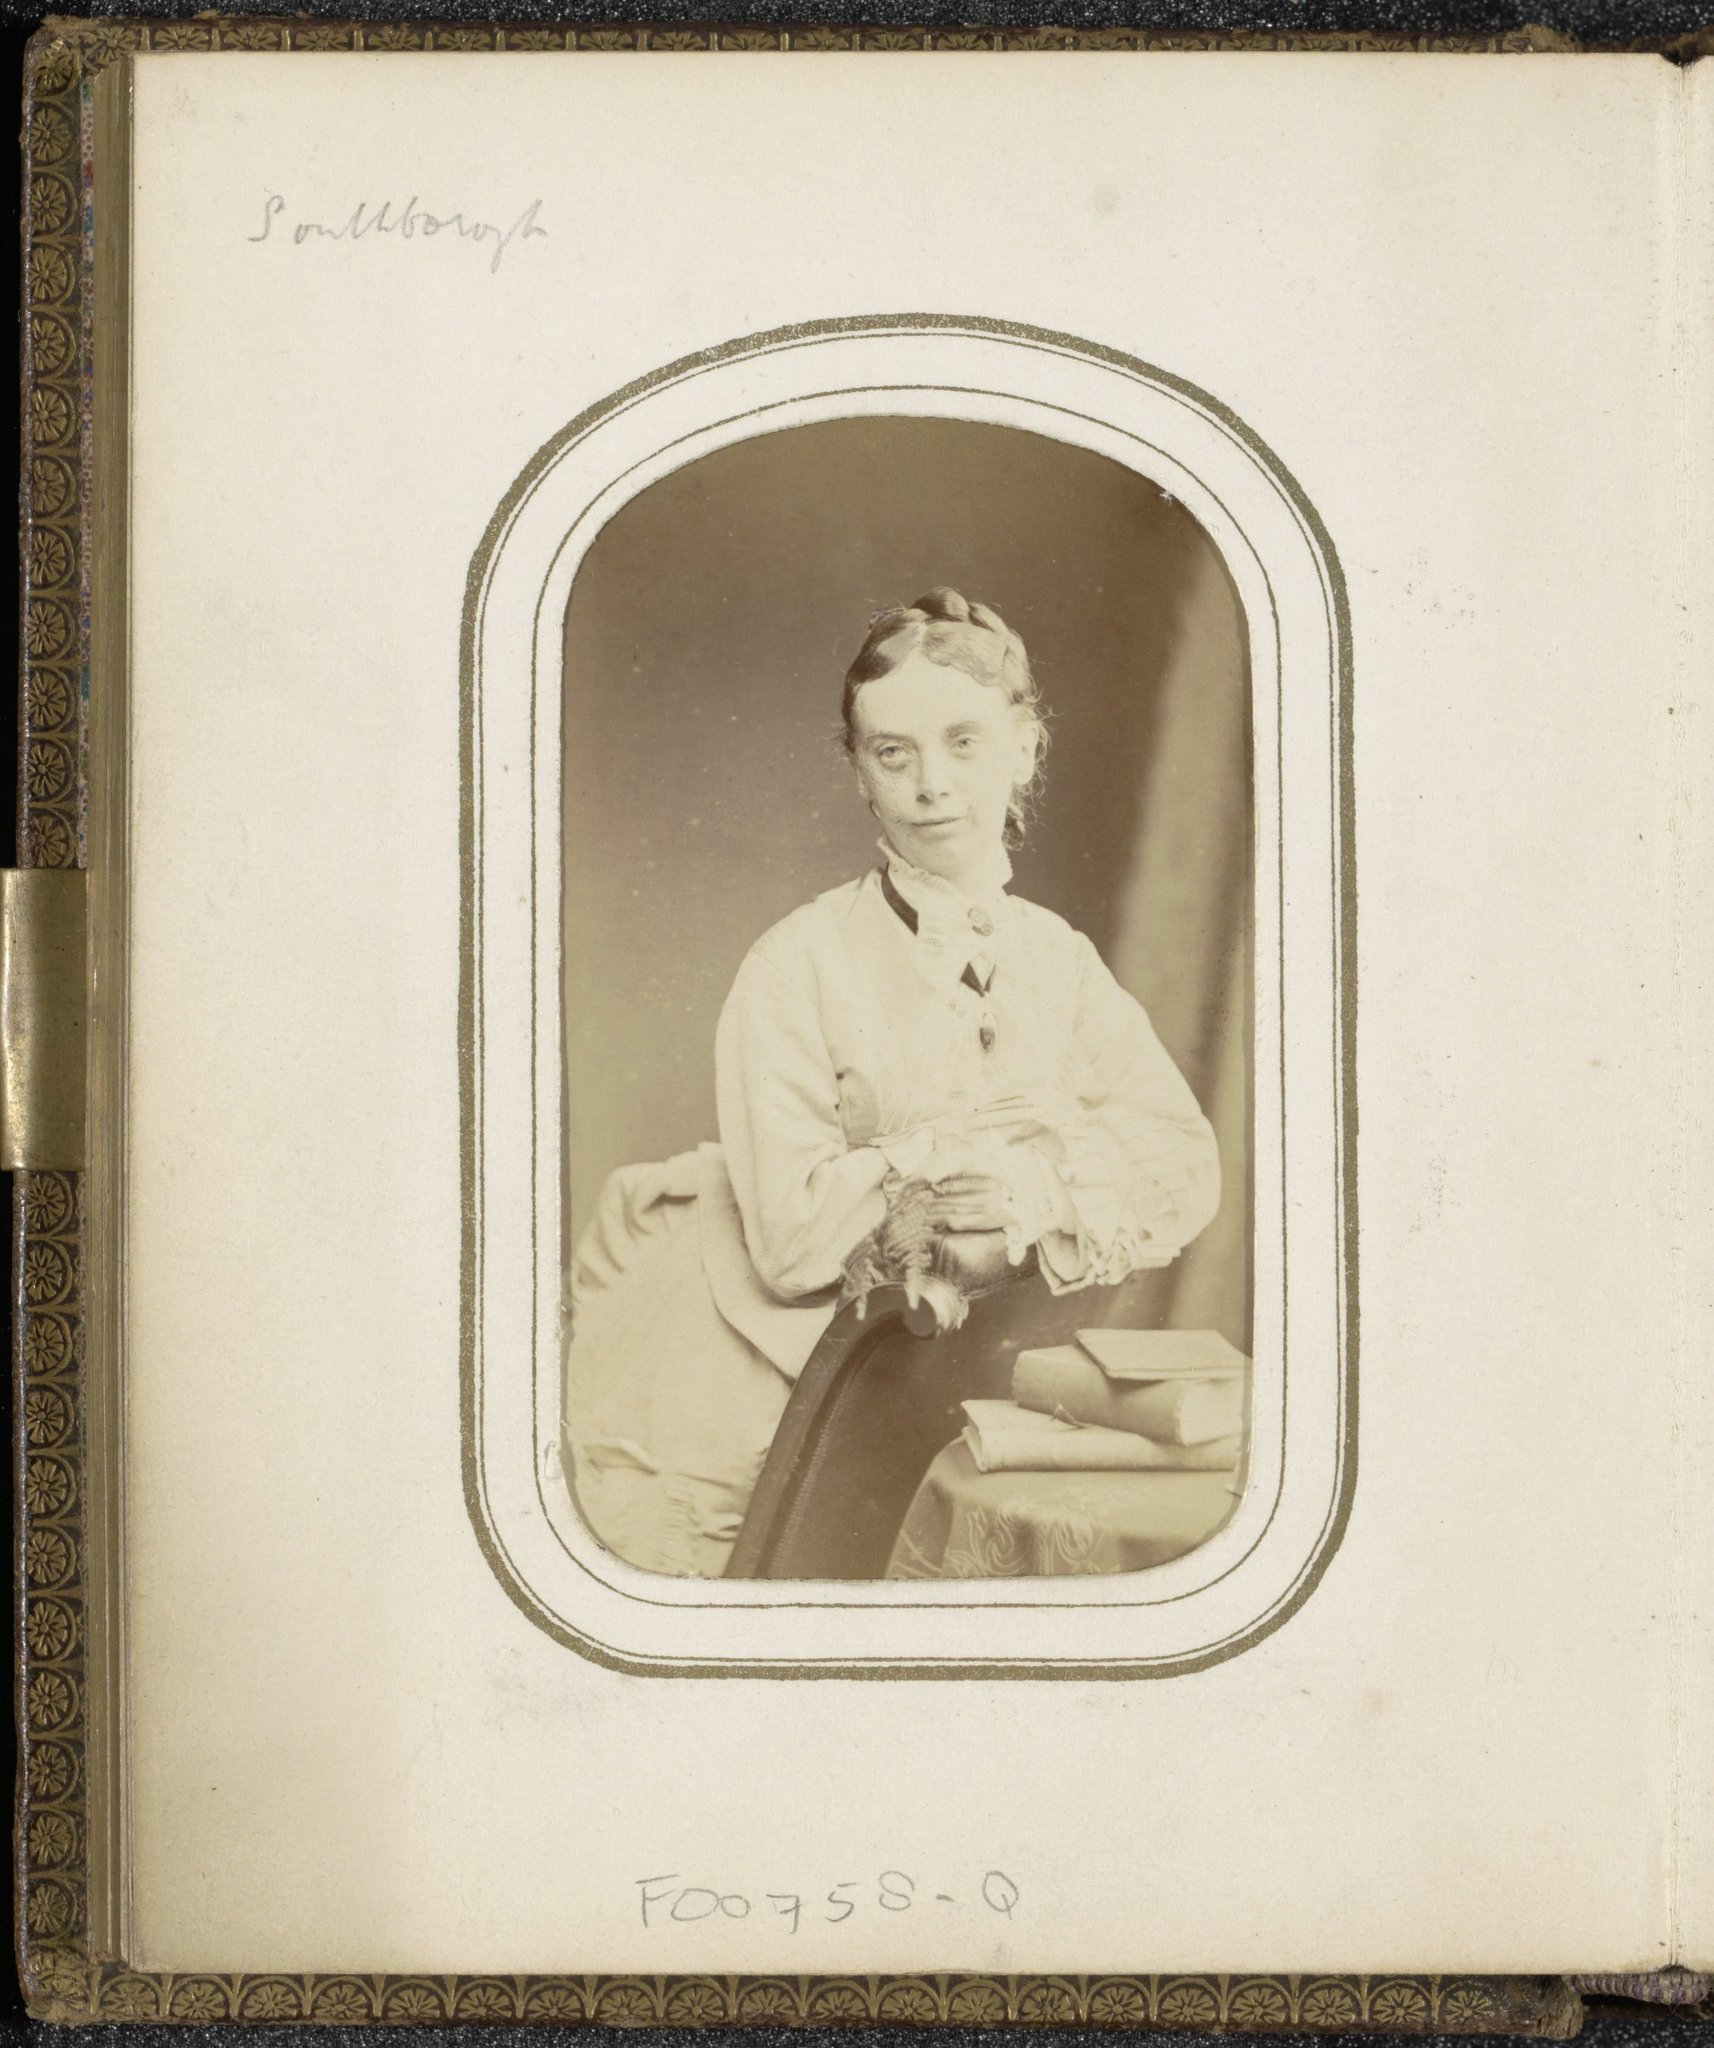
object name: carte de visite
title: Portret van een vrouw leunend op een fauteuil bij een tafel met boeken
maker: george glanville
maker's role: fotograaf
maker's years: 1846-1925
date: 1870-1880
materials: cardboard, paper, photographic support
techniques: albumen print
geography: tunbridge wells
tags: studio requisites ~ photographer, historical persons, clothing for the upper part of the body, book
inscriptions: inscription: ‘Southborogh’, address: ‘Tunbridge Wells, 5 High Street’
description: Onderdeel van Engels fotoalbum van E.A. Kettle met 42 cartes-de-visite.